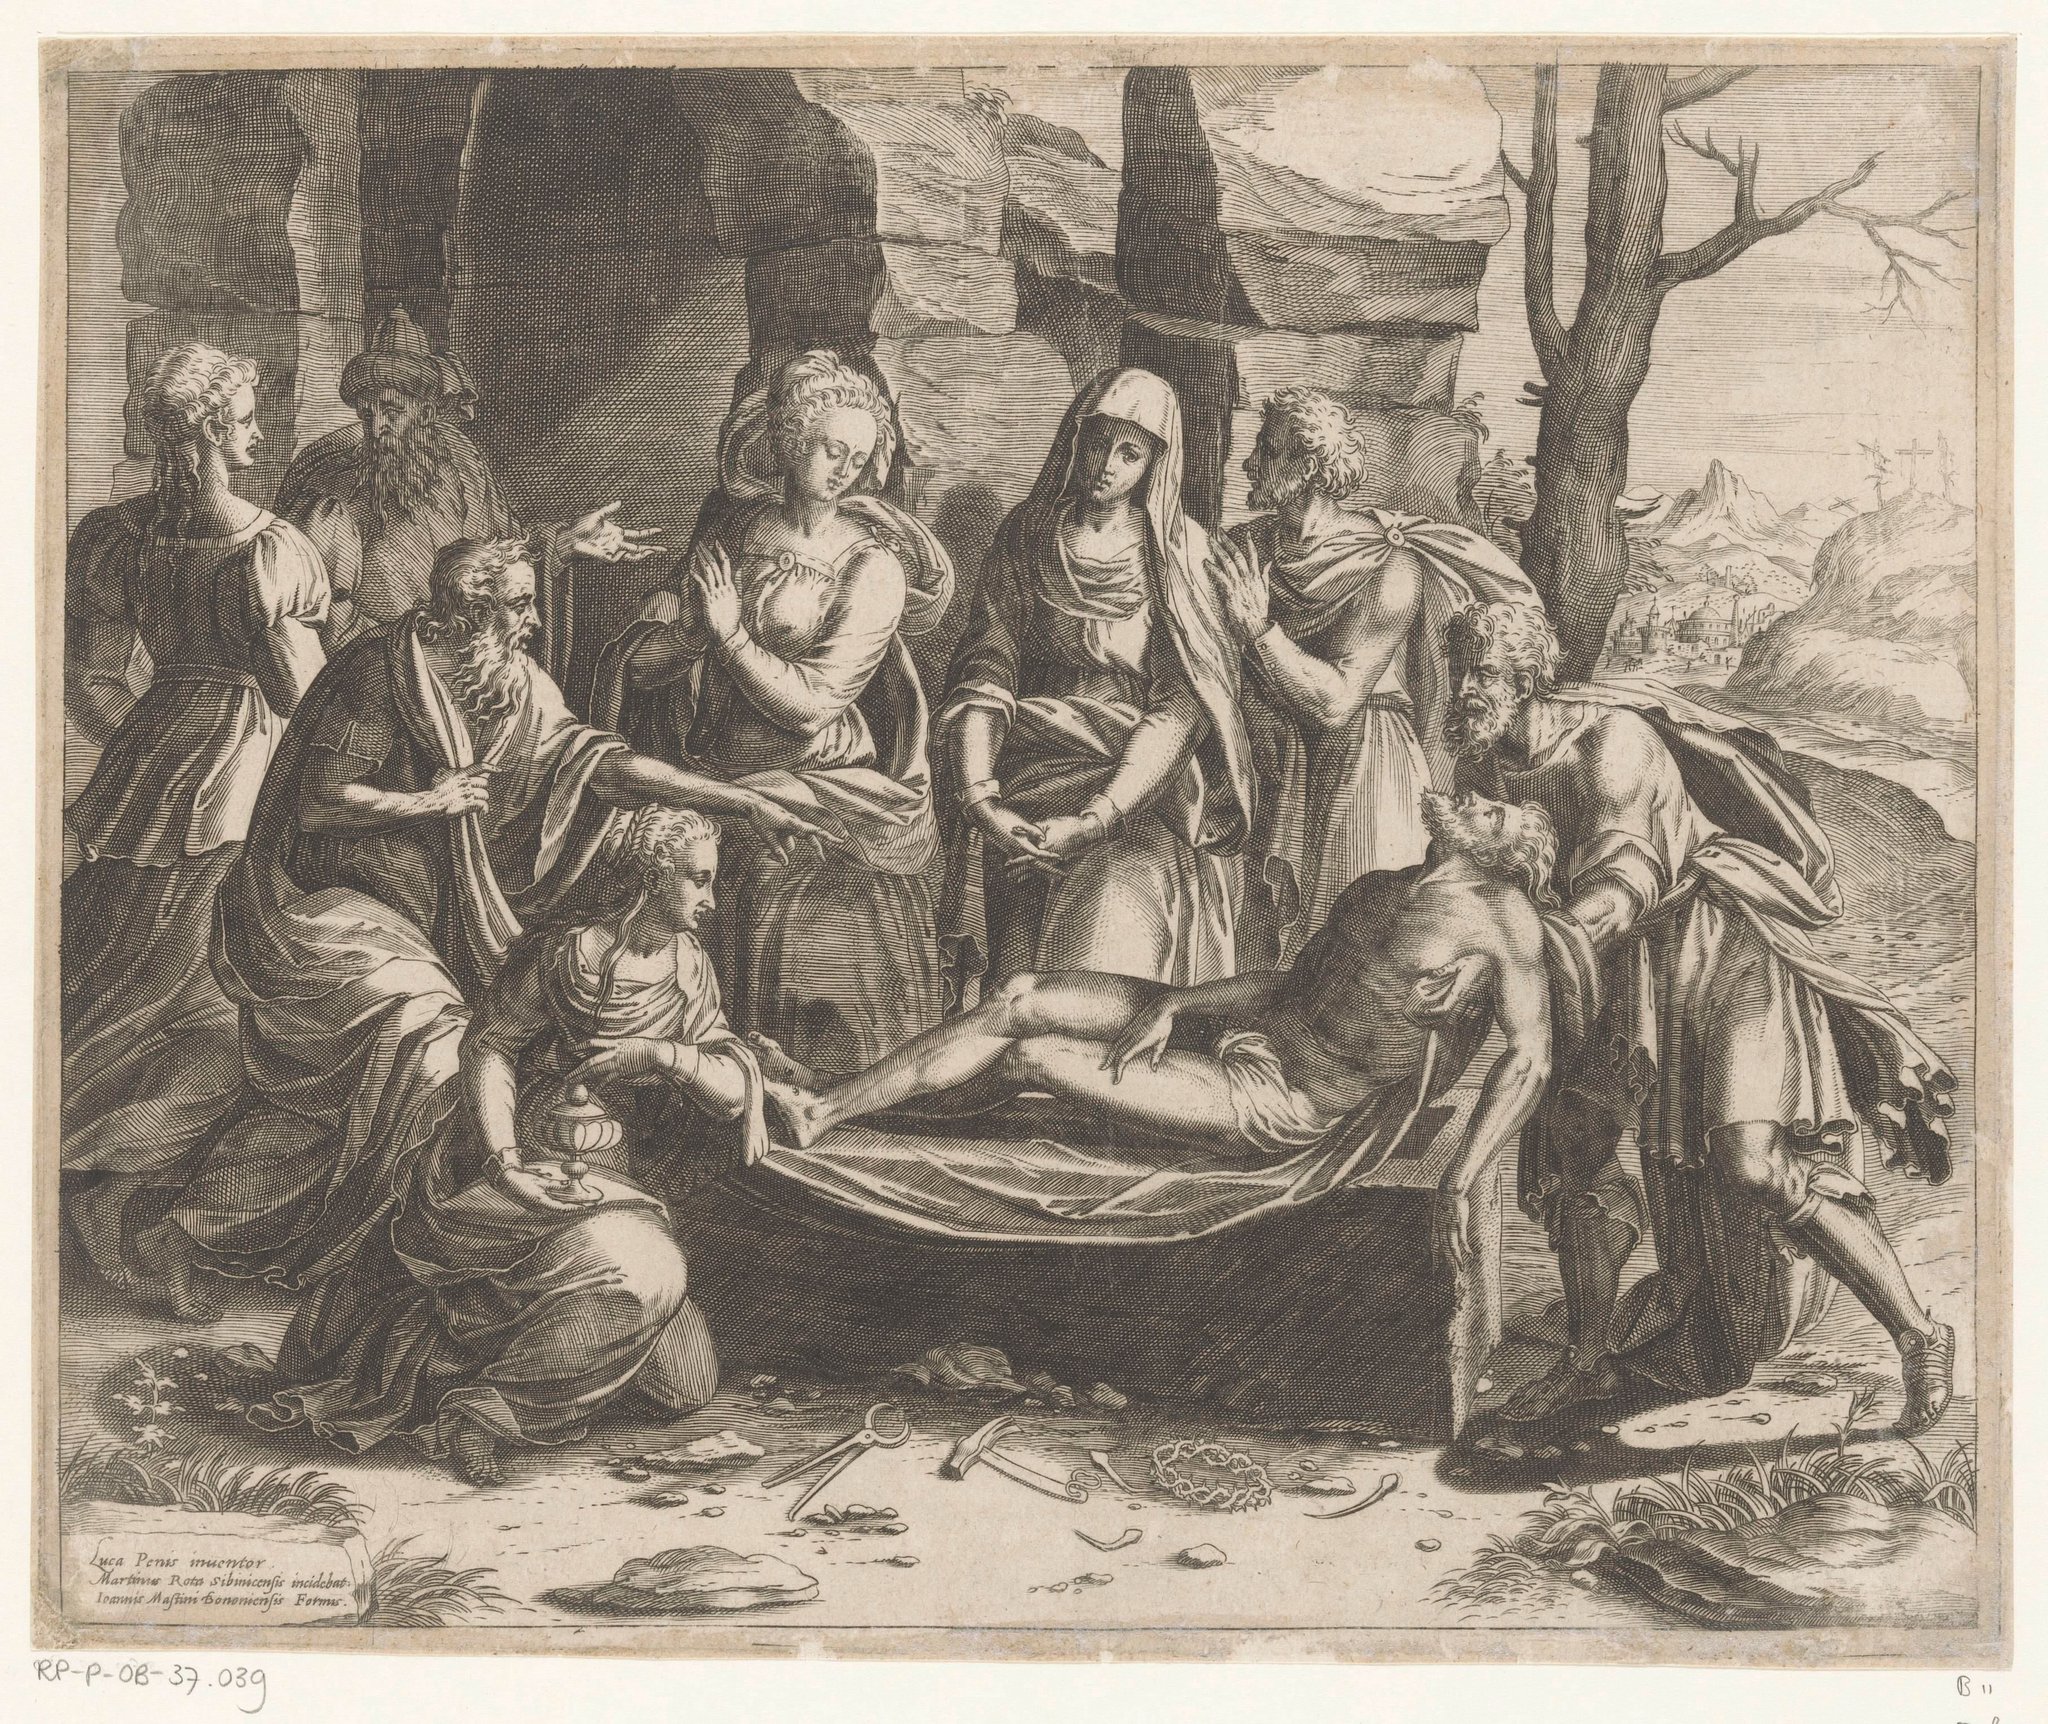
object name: print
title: Graflegging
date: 1530-1583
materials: paper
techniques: engraving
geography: italy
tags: christ's entombment (possibly by angels)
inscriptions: collector's mark: Lugt 240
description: Christus wordt in zijn graf geplaatst. Rond het graf treuren Maria, Johannes de Evangelist, Maria Magdalena en anderen. Op de voorgrond liggen de passiewerktuigen.